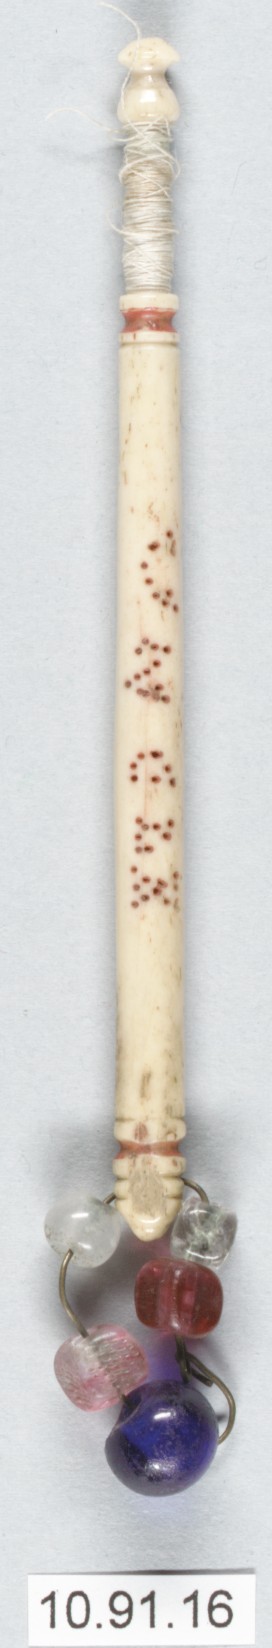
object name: bobbin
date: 1801-1900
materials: bone